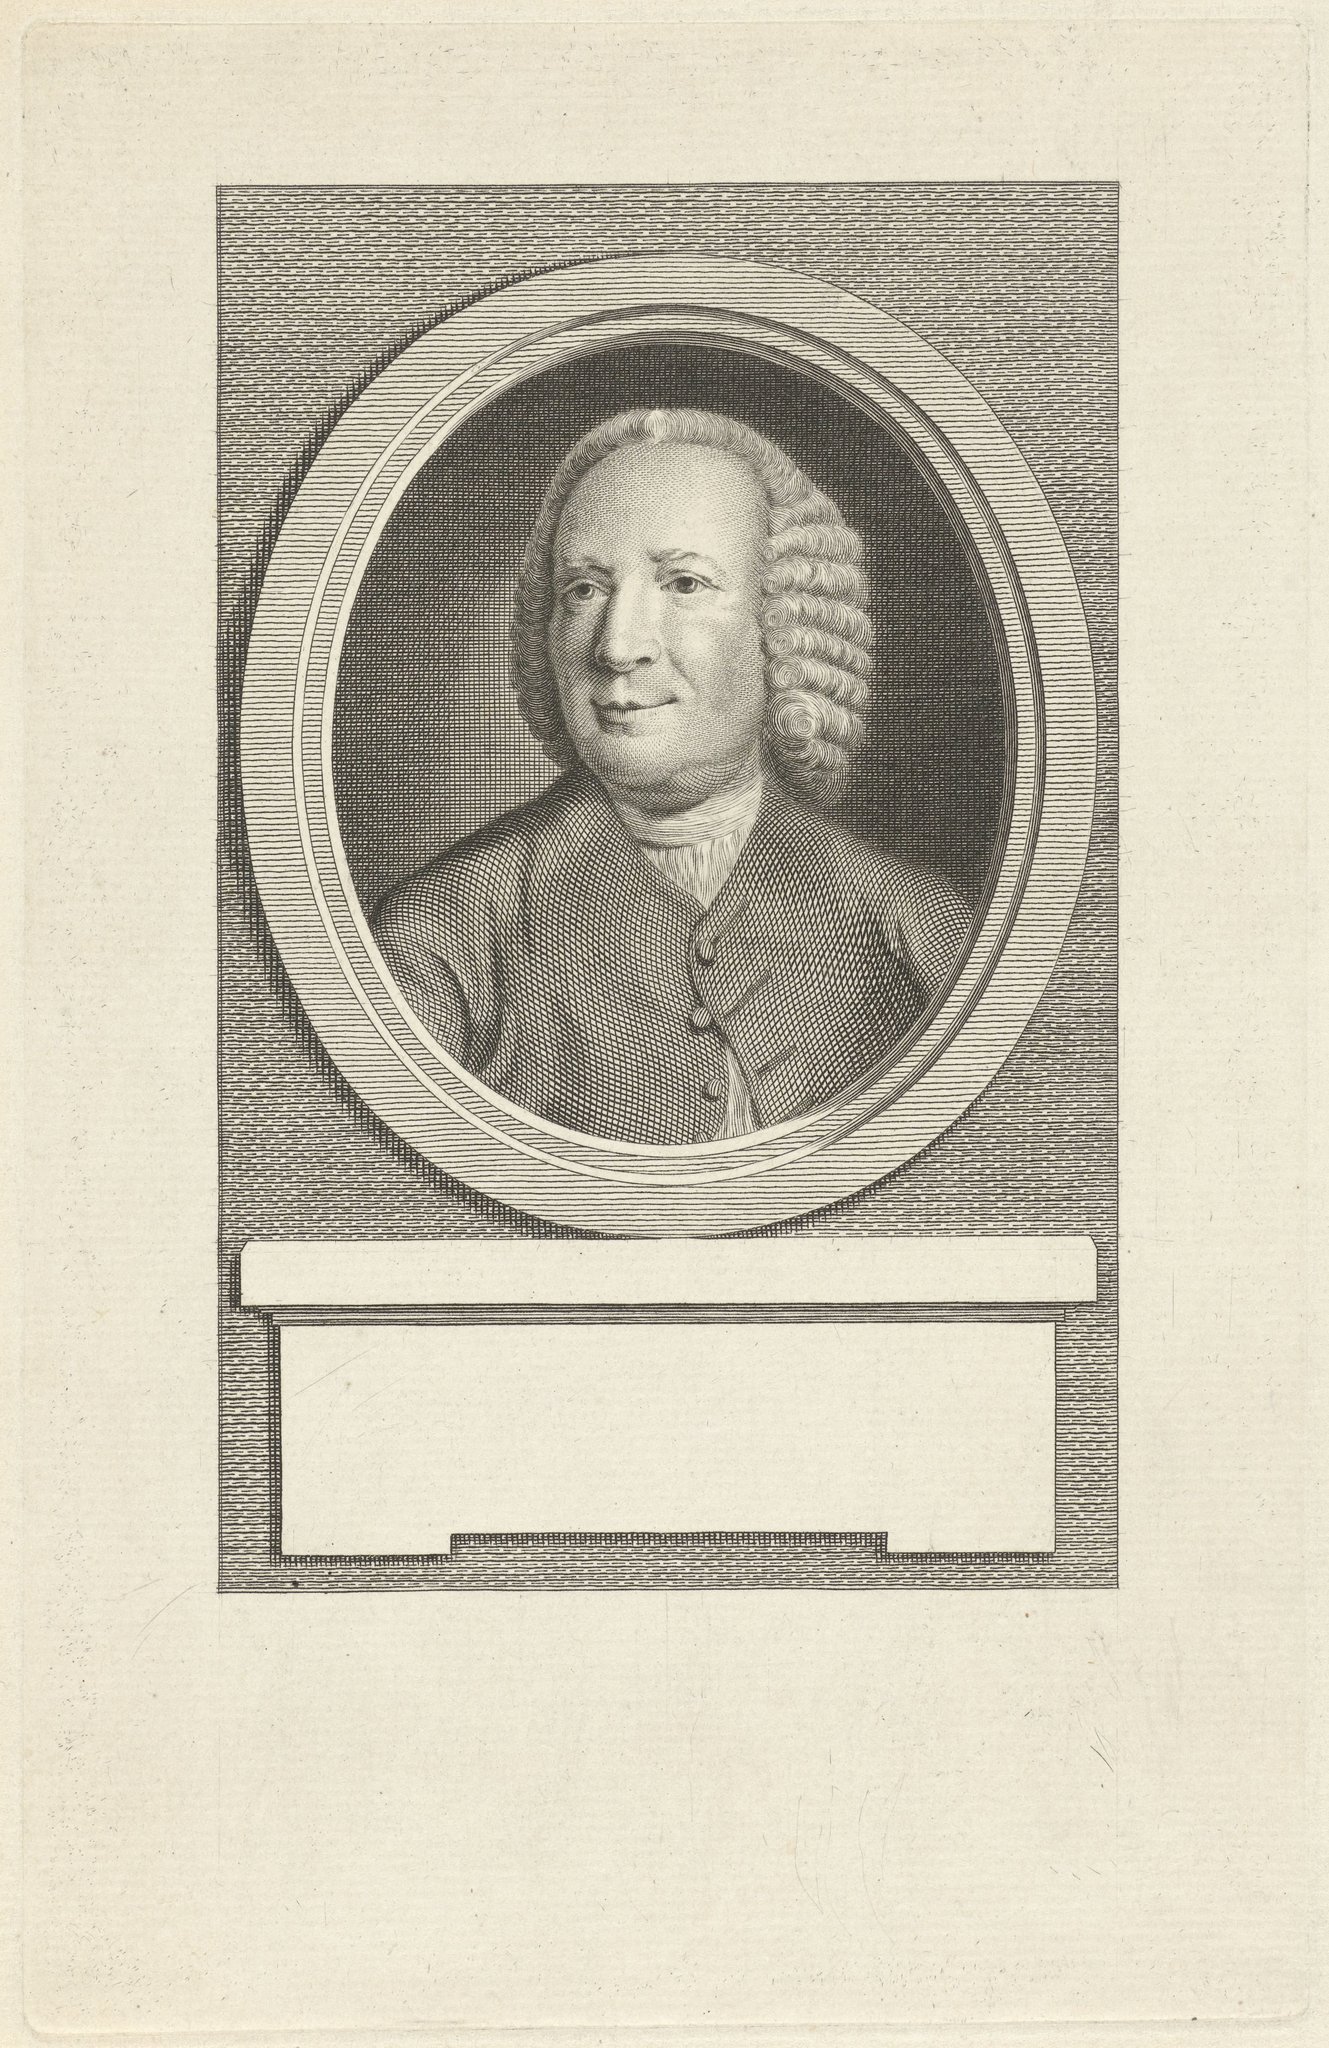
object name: print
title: Portret van Arnold Hoogvliet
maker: pieter willem van megen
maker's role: print maker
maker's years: 1750-1785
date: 1760-1785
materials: paper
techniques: engraving, etching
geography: the hague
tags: arnold hoogvliet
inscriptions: inscription: ‘Pecker.’, collector's mark: Lugt 240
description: Portret van de dichter Arnold Hoogvliet in een ovale lijst.